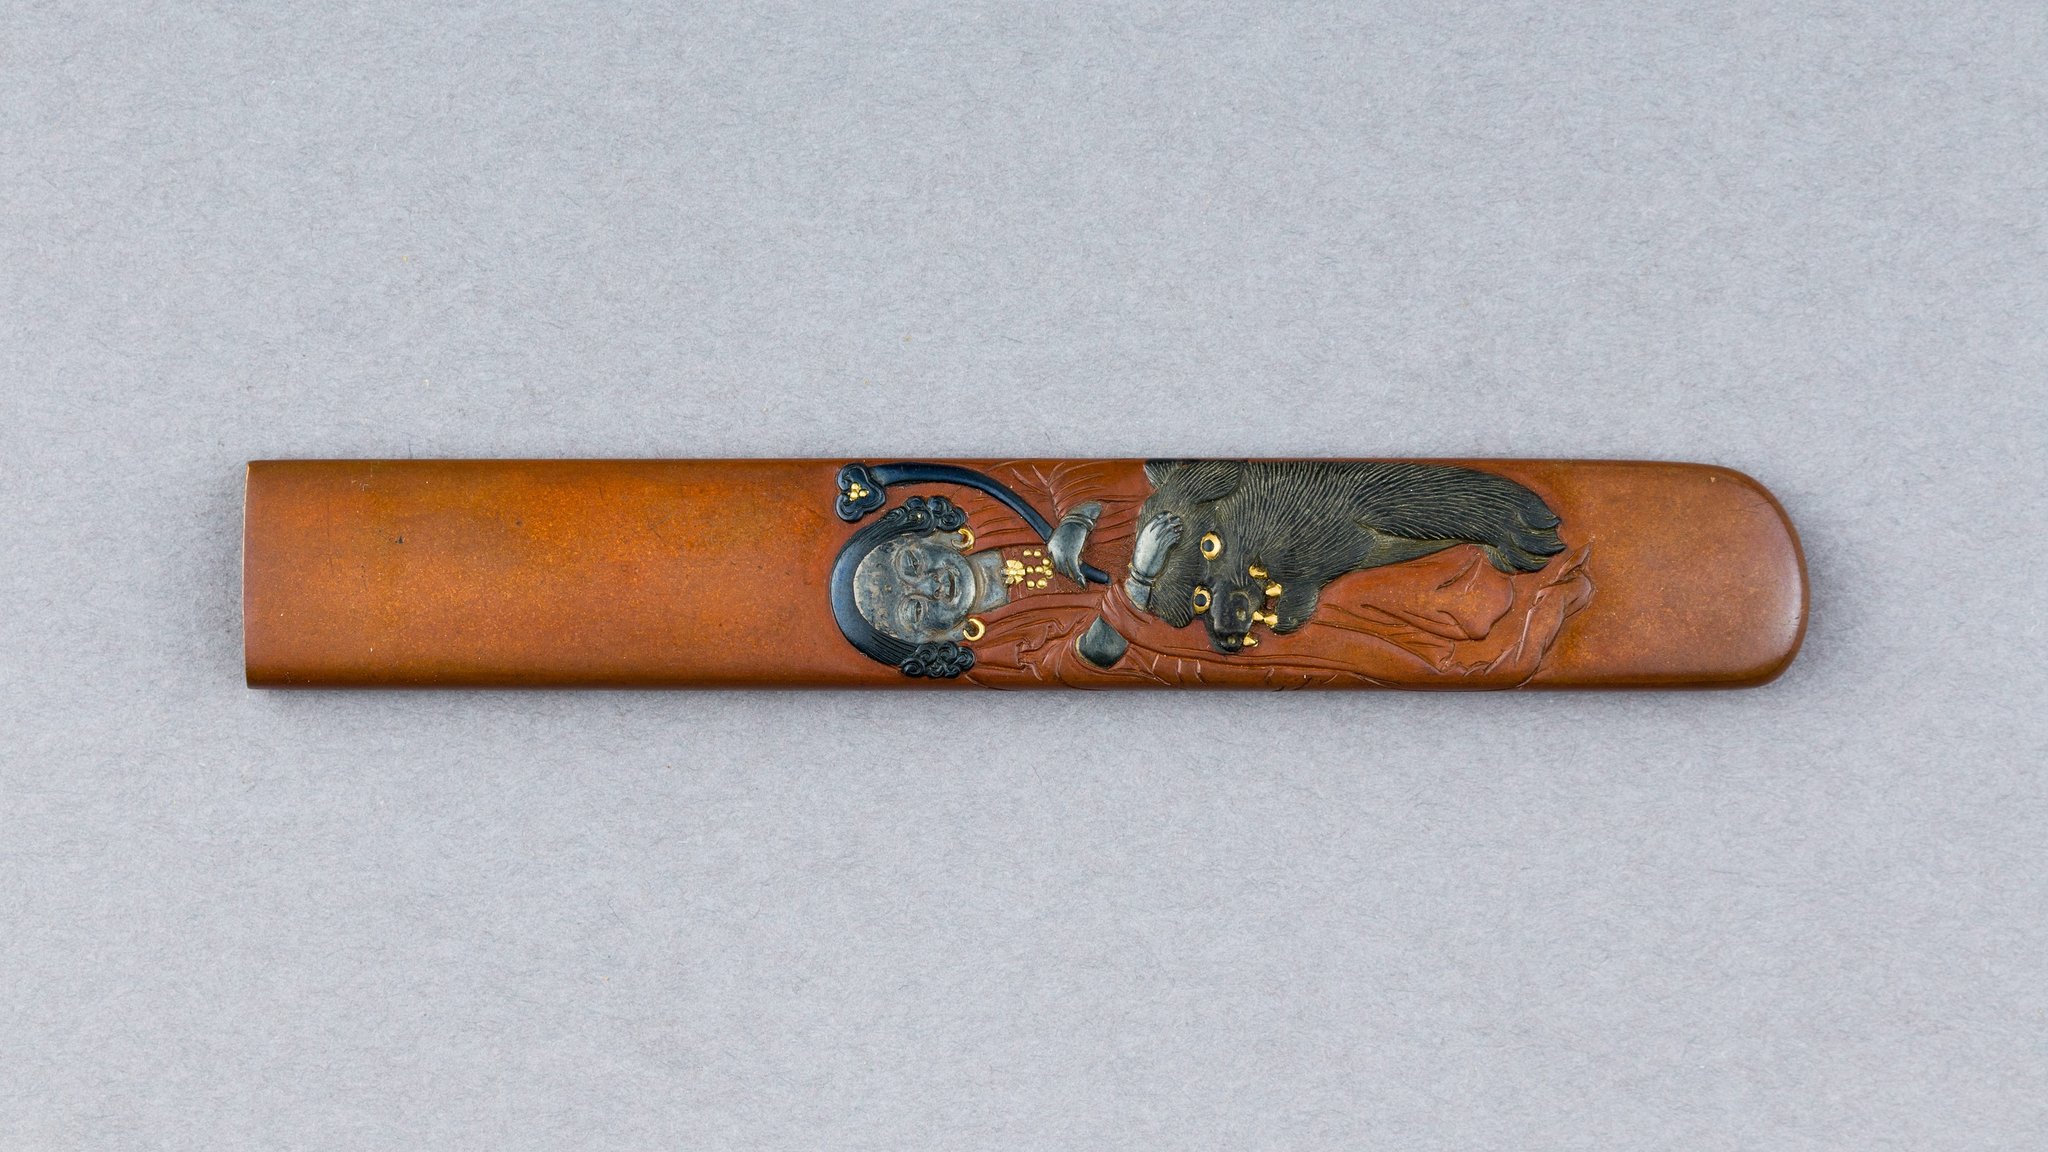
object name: knife handle kozuka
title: Knife Handle (Kozuka)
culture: japanese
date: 1615-1868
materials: copper, gold alloy, silver alloy, gold, silver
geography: japan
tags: human figures,animals